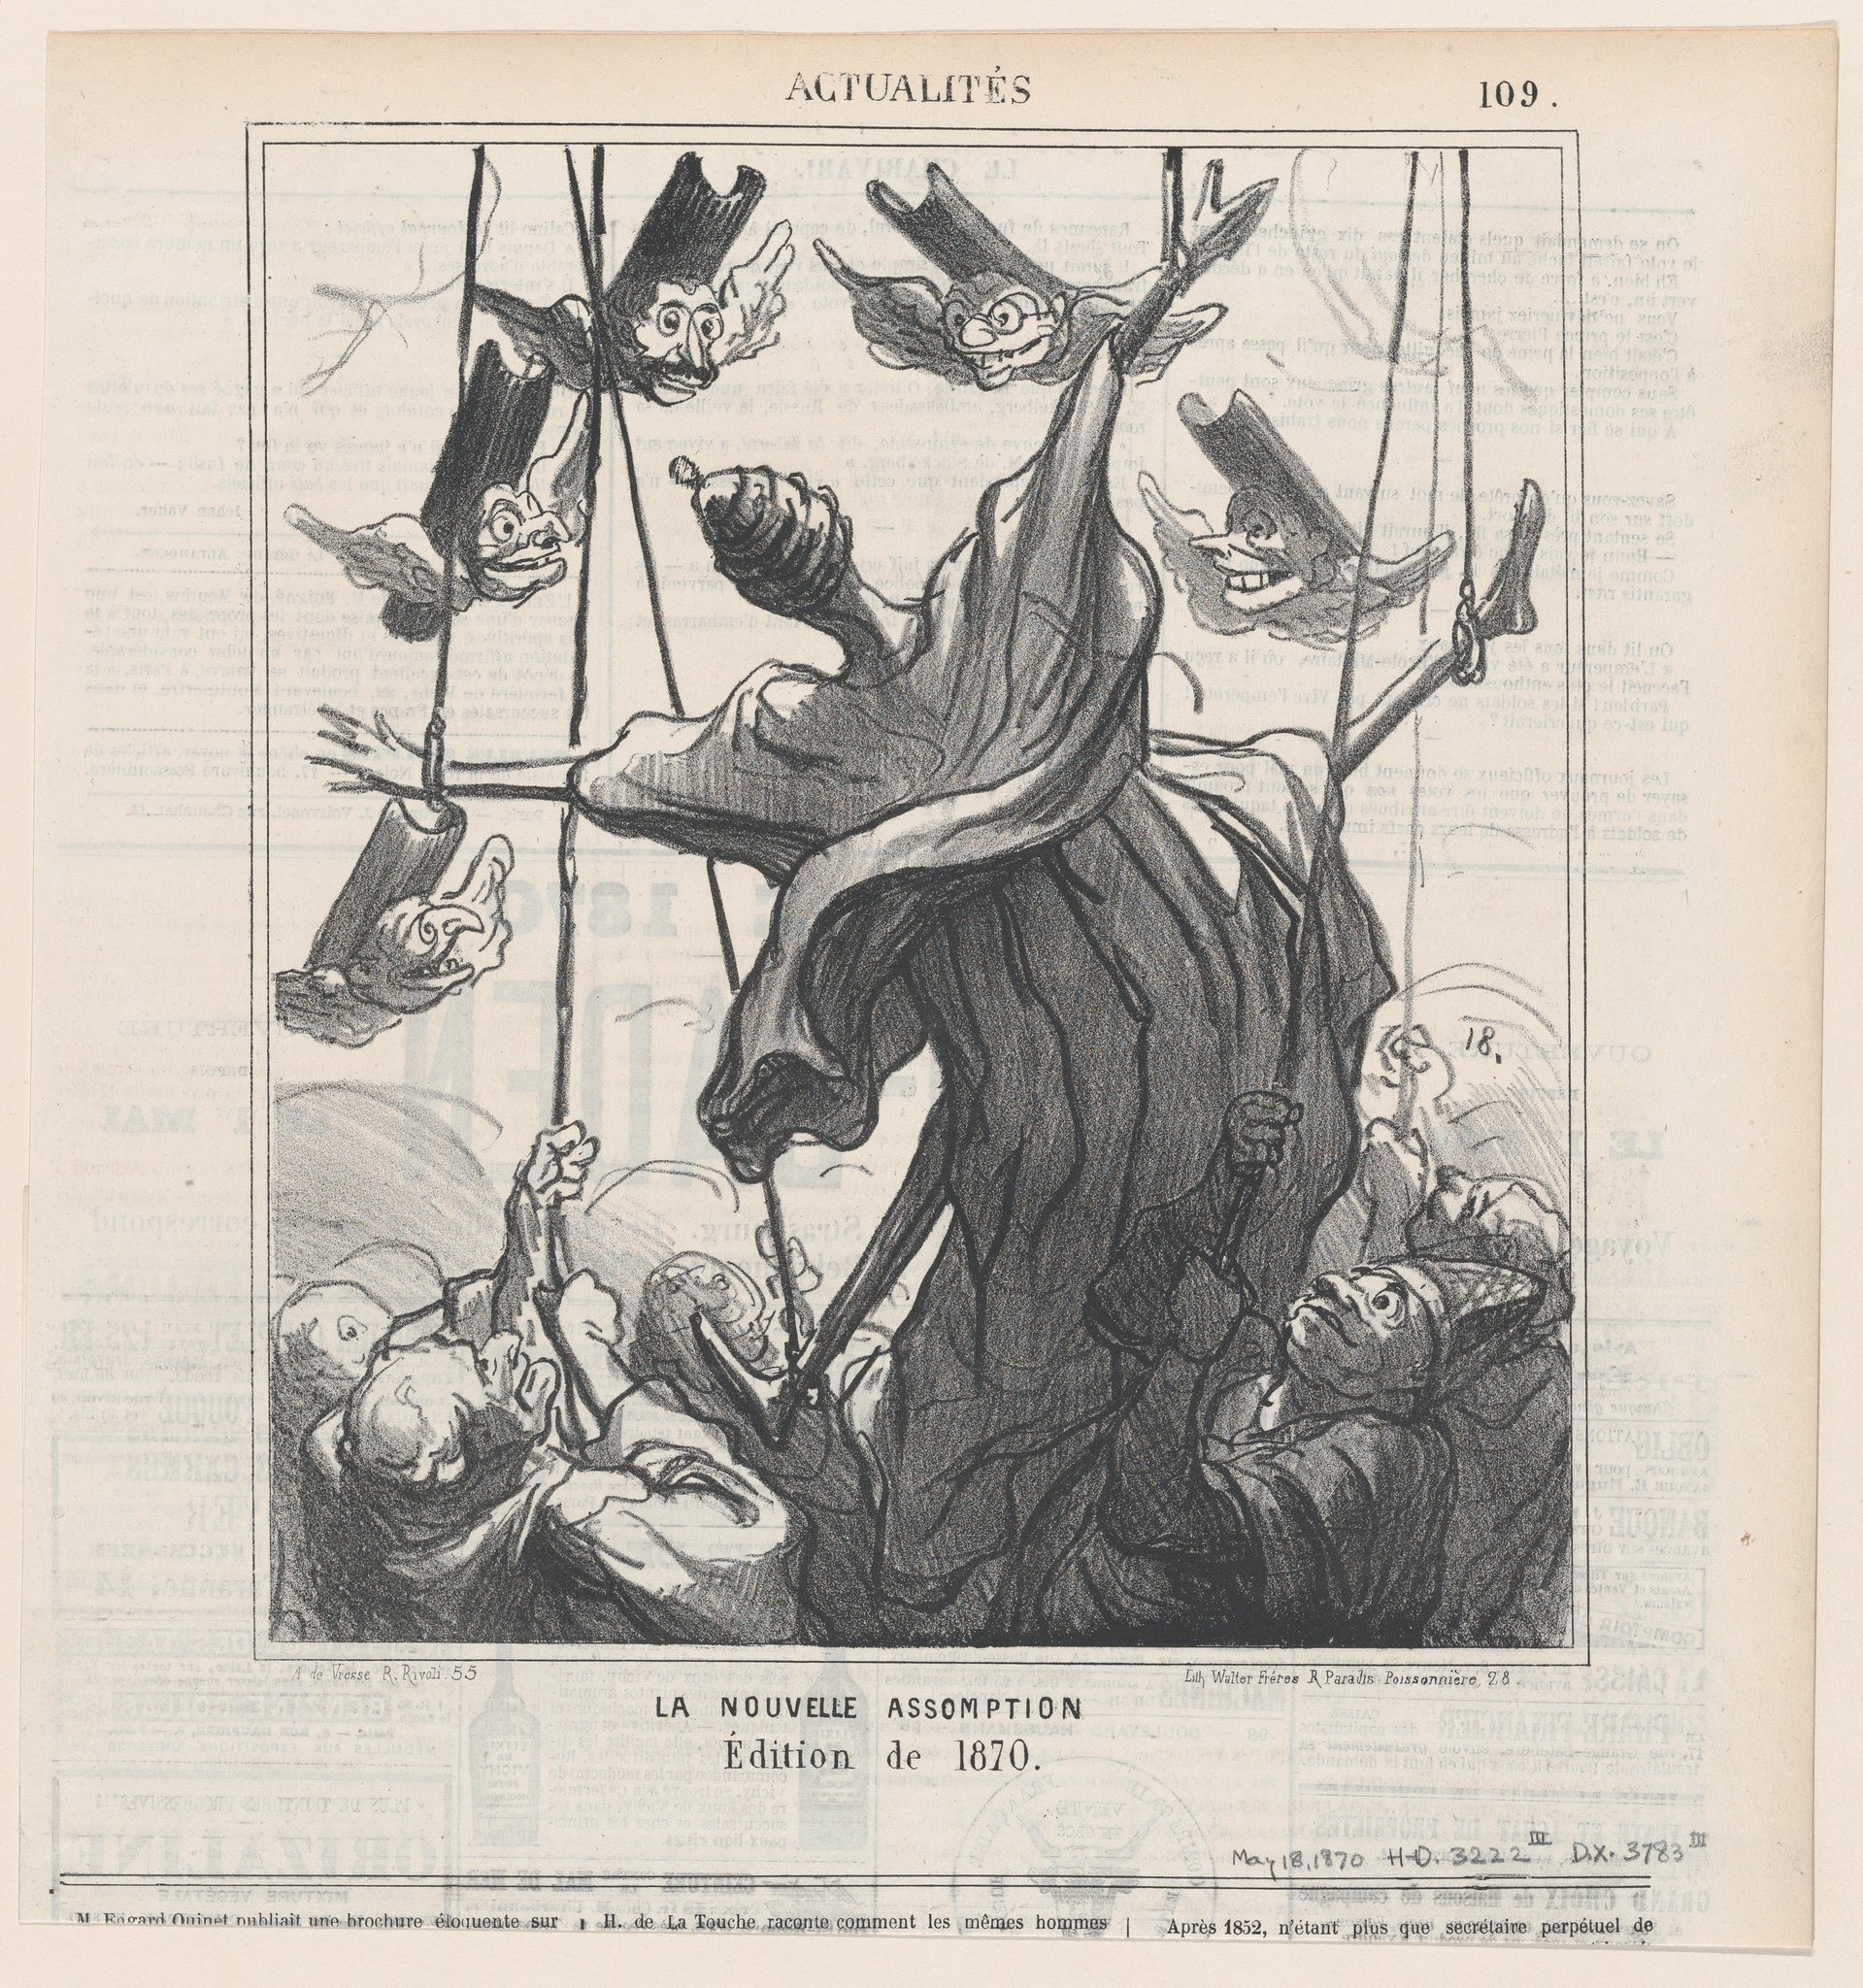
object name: print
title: The new assumption, 1870 edition, from 'News of the day,' published in Le Charivari, May 18, 1870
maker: honoré daumier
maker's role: artist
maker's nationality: french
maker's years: 1808-1879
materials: paper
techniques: lithograph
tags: satire,men